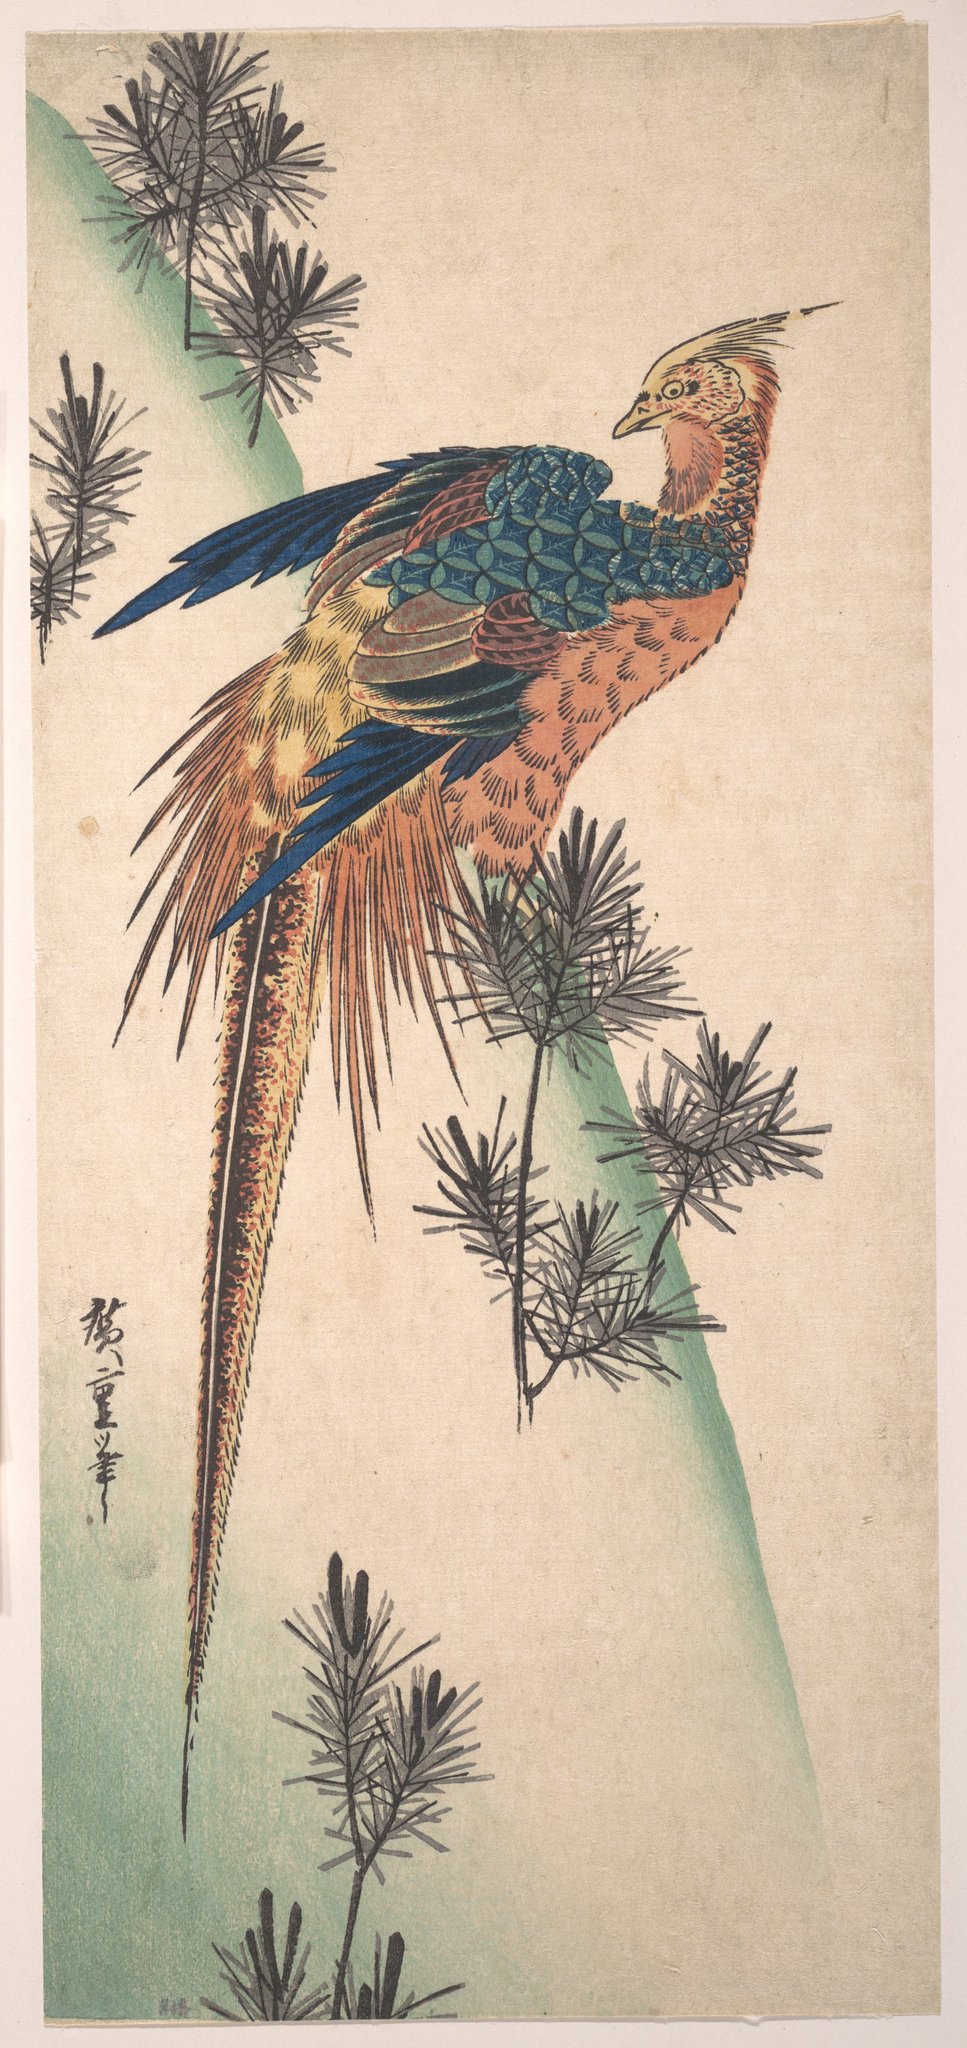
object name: print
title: Pheasant and Pine-trees on Snowy Hillside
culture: japanese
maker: utagawa hiroshige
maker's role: artist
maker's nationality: japanese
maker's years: 1797-1858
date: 1797-1858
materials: ink, paper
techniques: woodblock print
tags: pheasants,trees